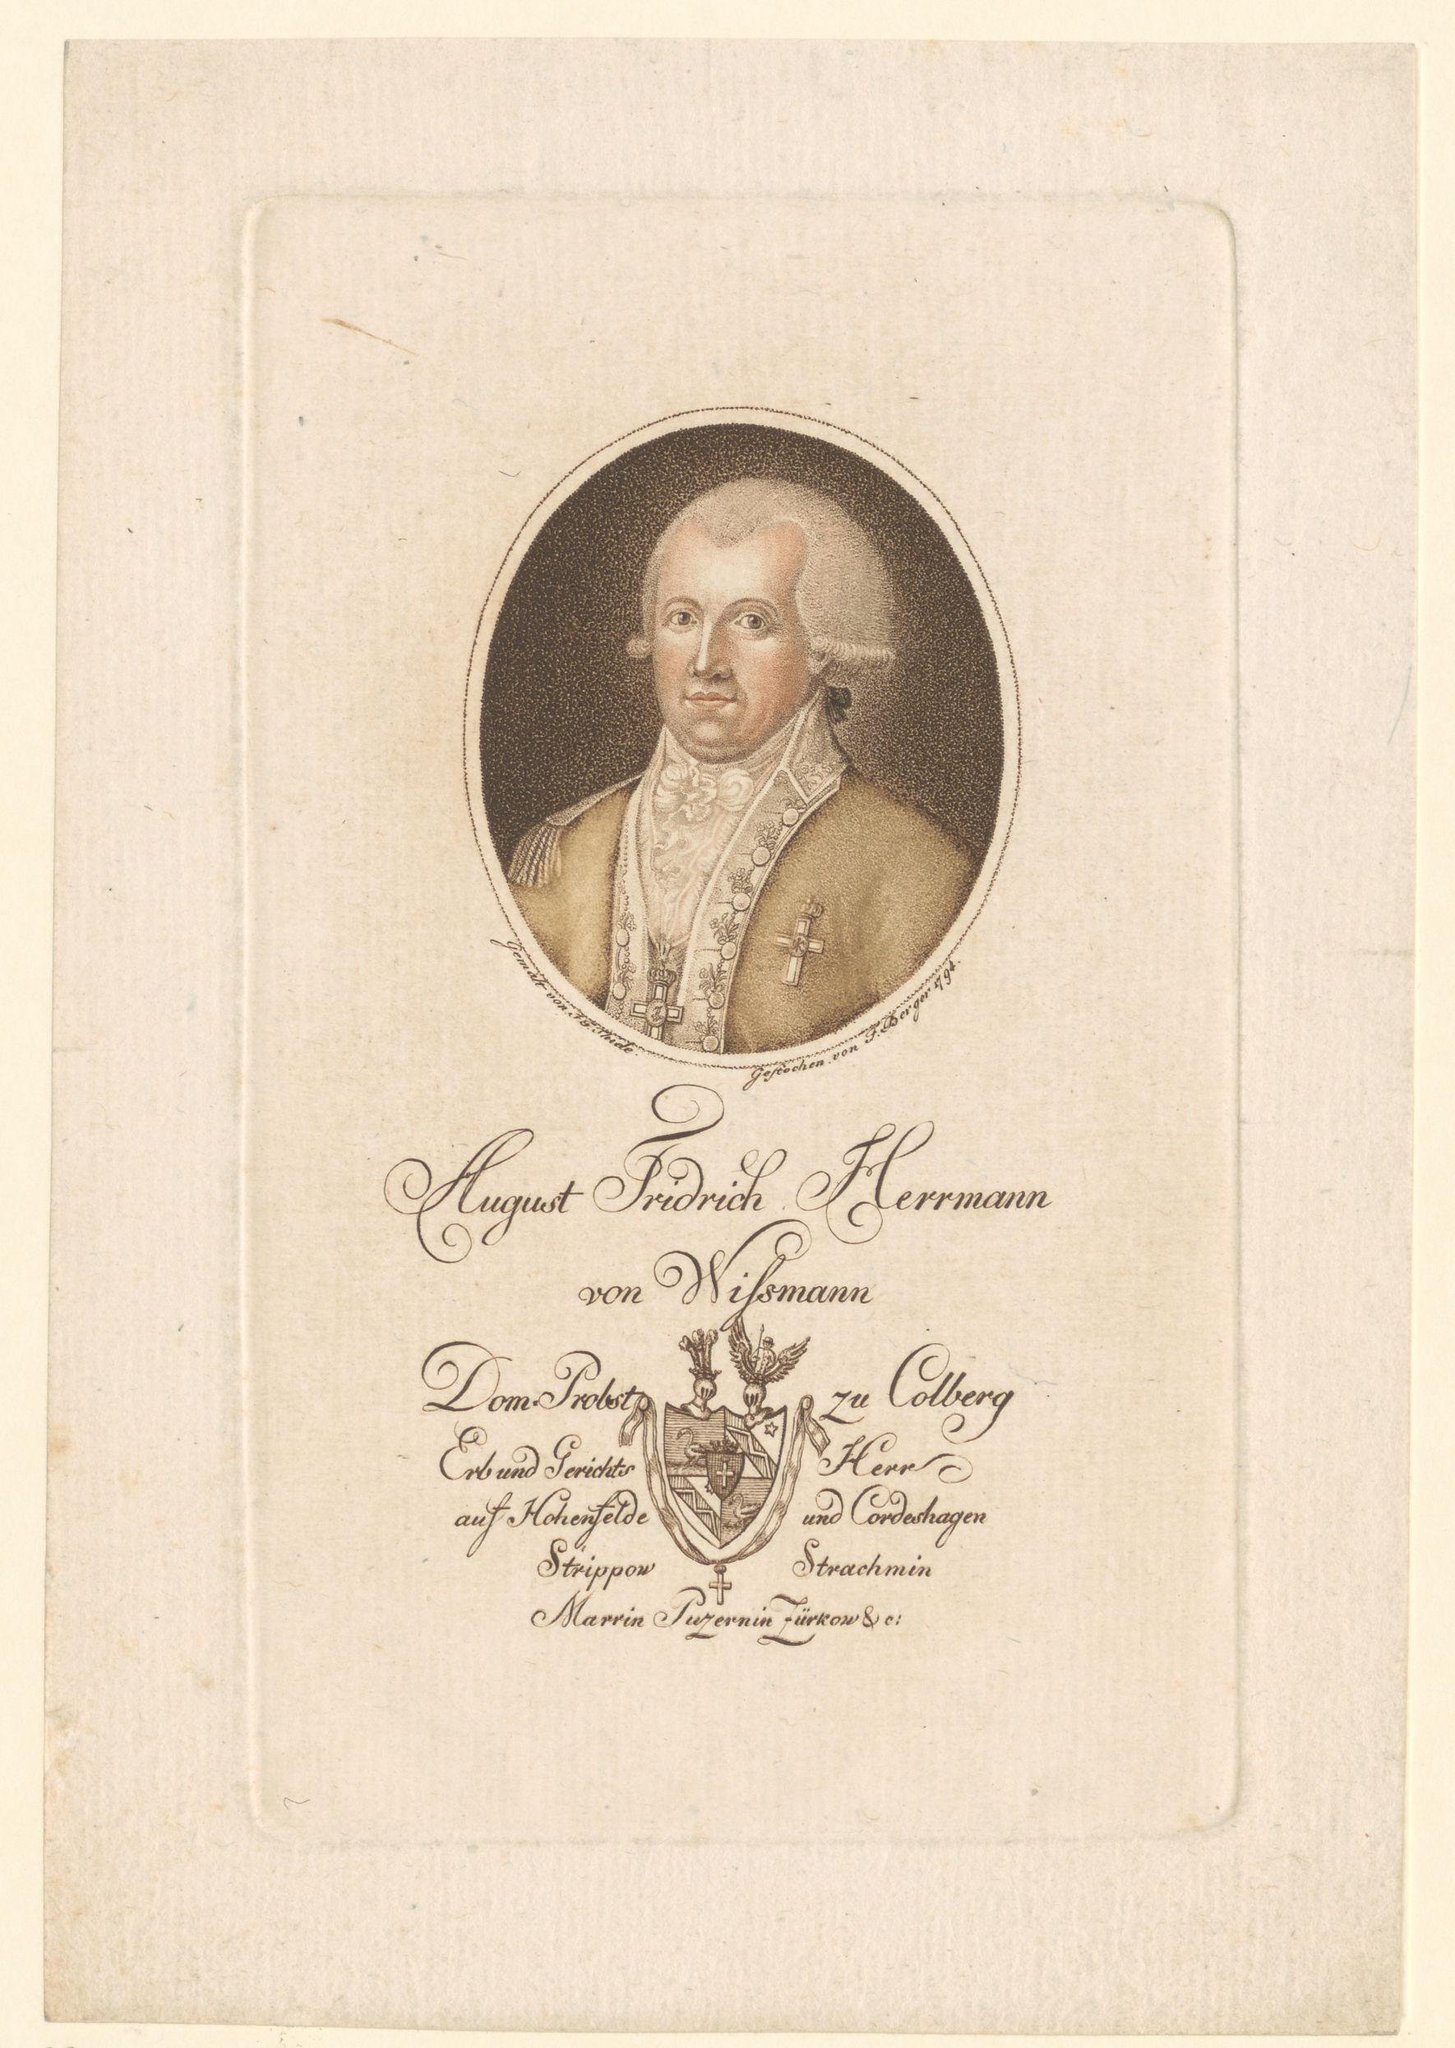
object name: print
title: Portret van August Friedrich Hermann Wissmann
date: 1794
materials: paper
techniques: color etching, stippling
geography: berlin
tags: historical persons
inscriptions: collector's mark: Lugt 2228